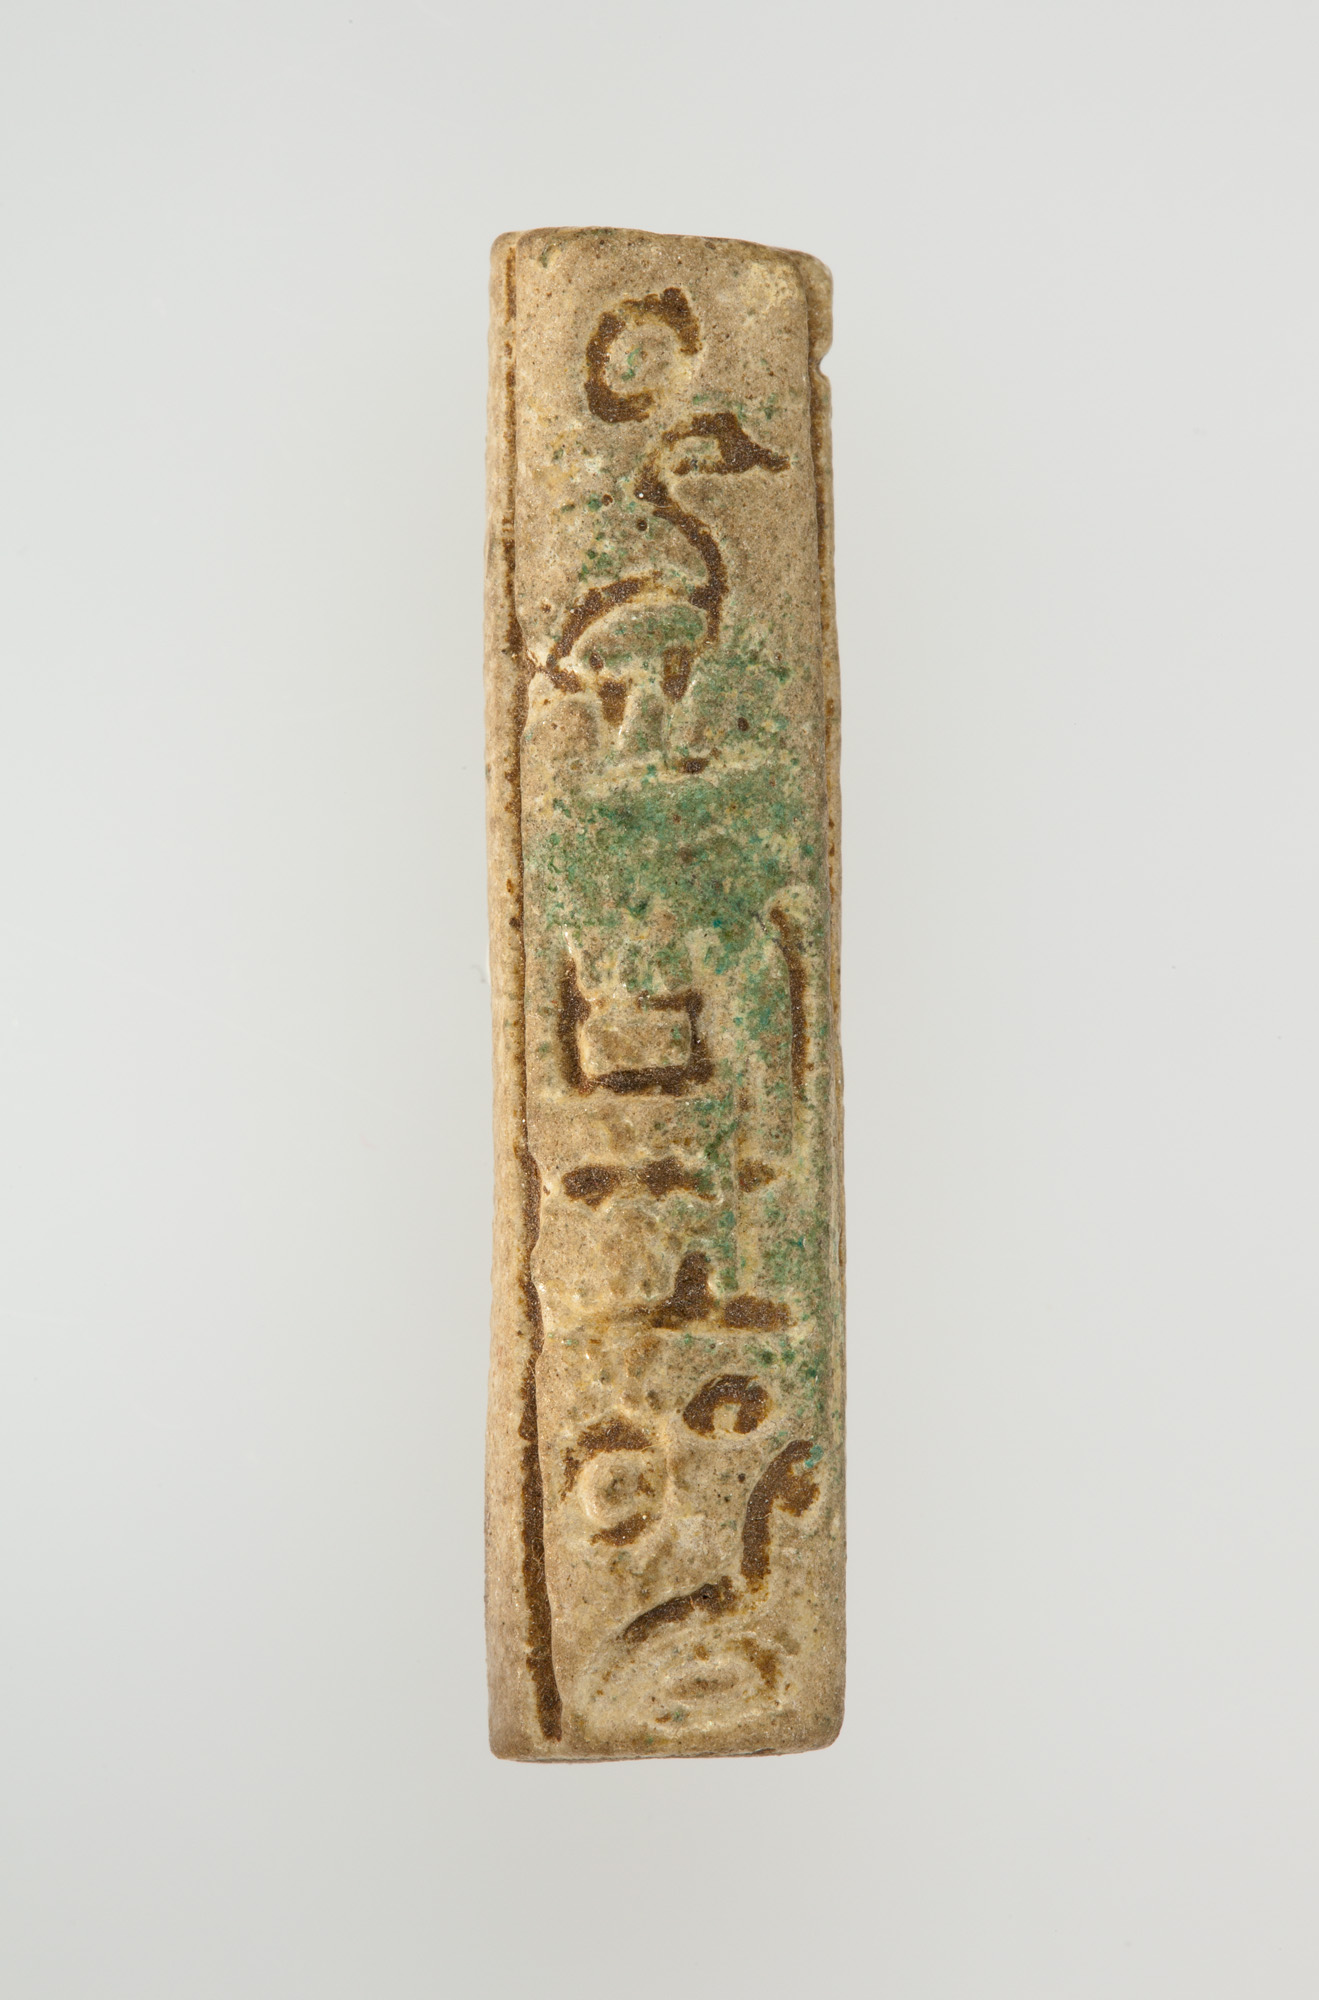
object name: scarab, amenhotep i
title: Cylinder bead inscribed with the name Amenhotep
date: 1525-1504 BCE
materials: stone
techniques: glazing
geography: egypt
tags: hieroglyphs